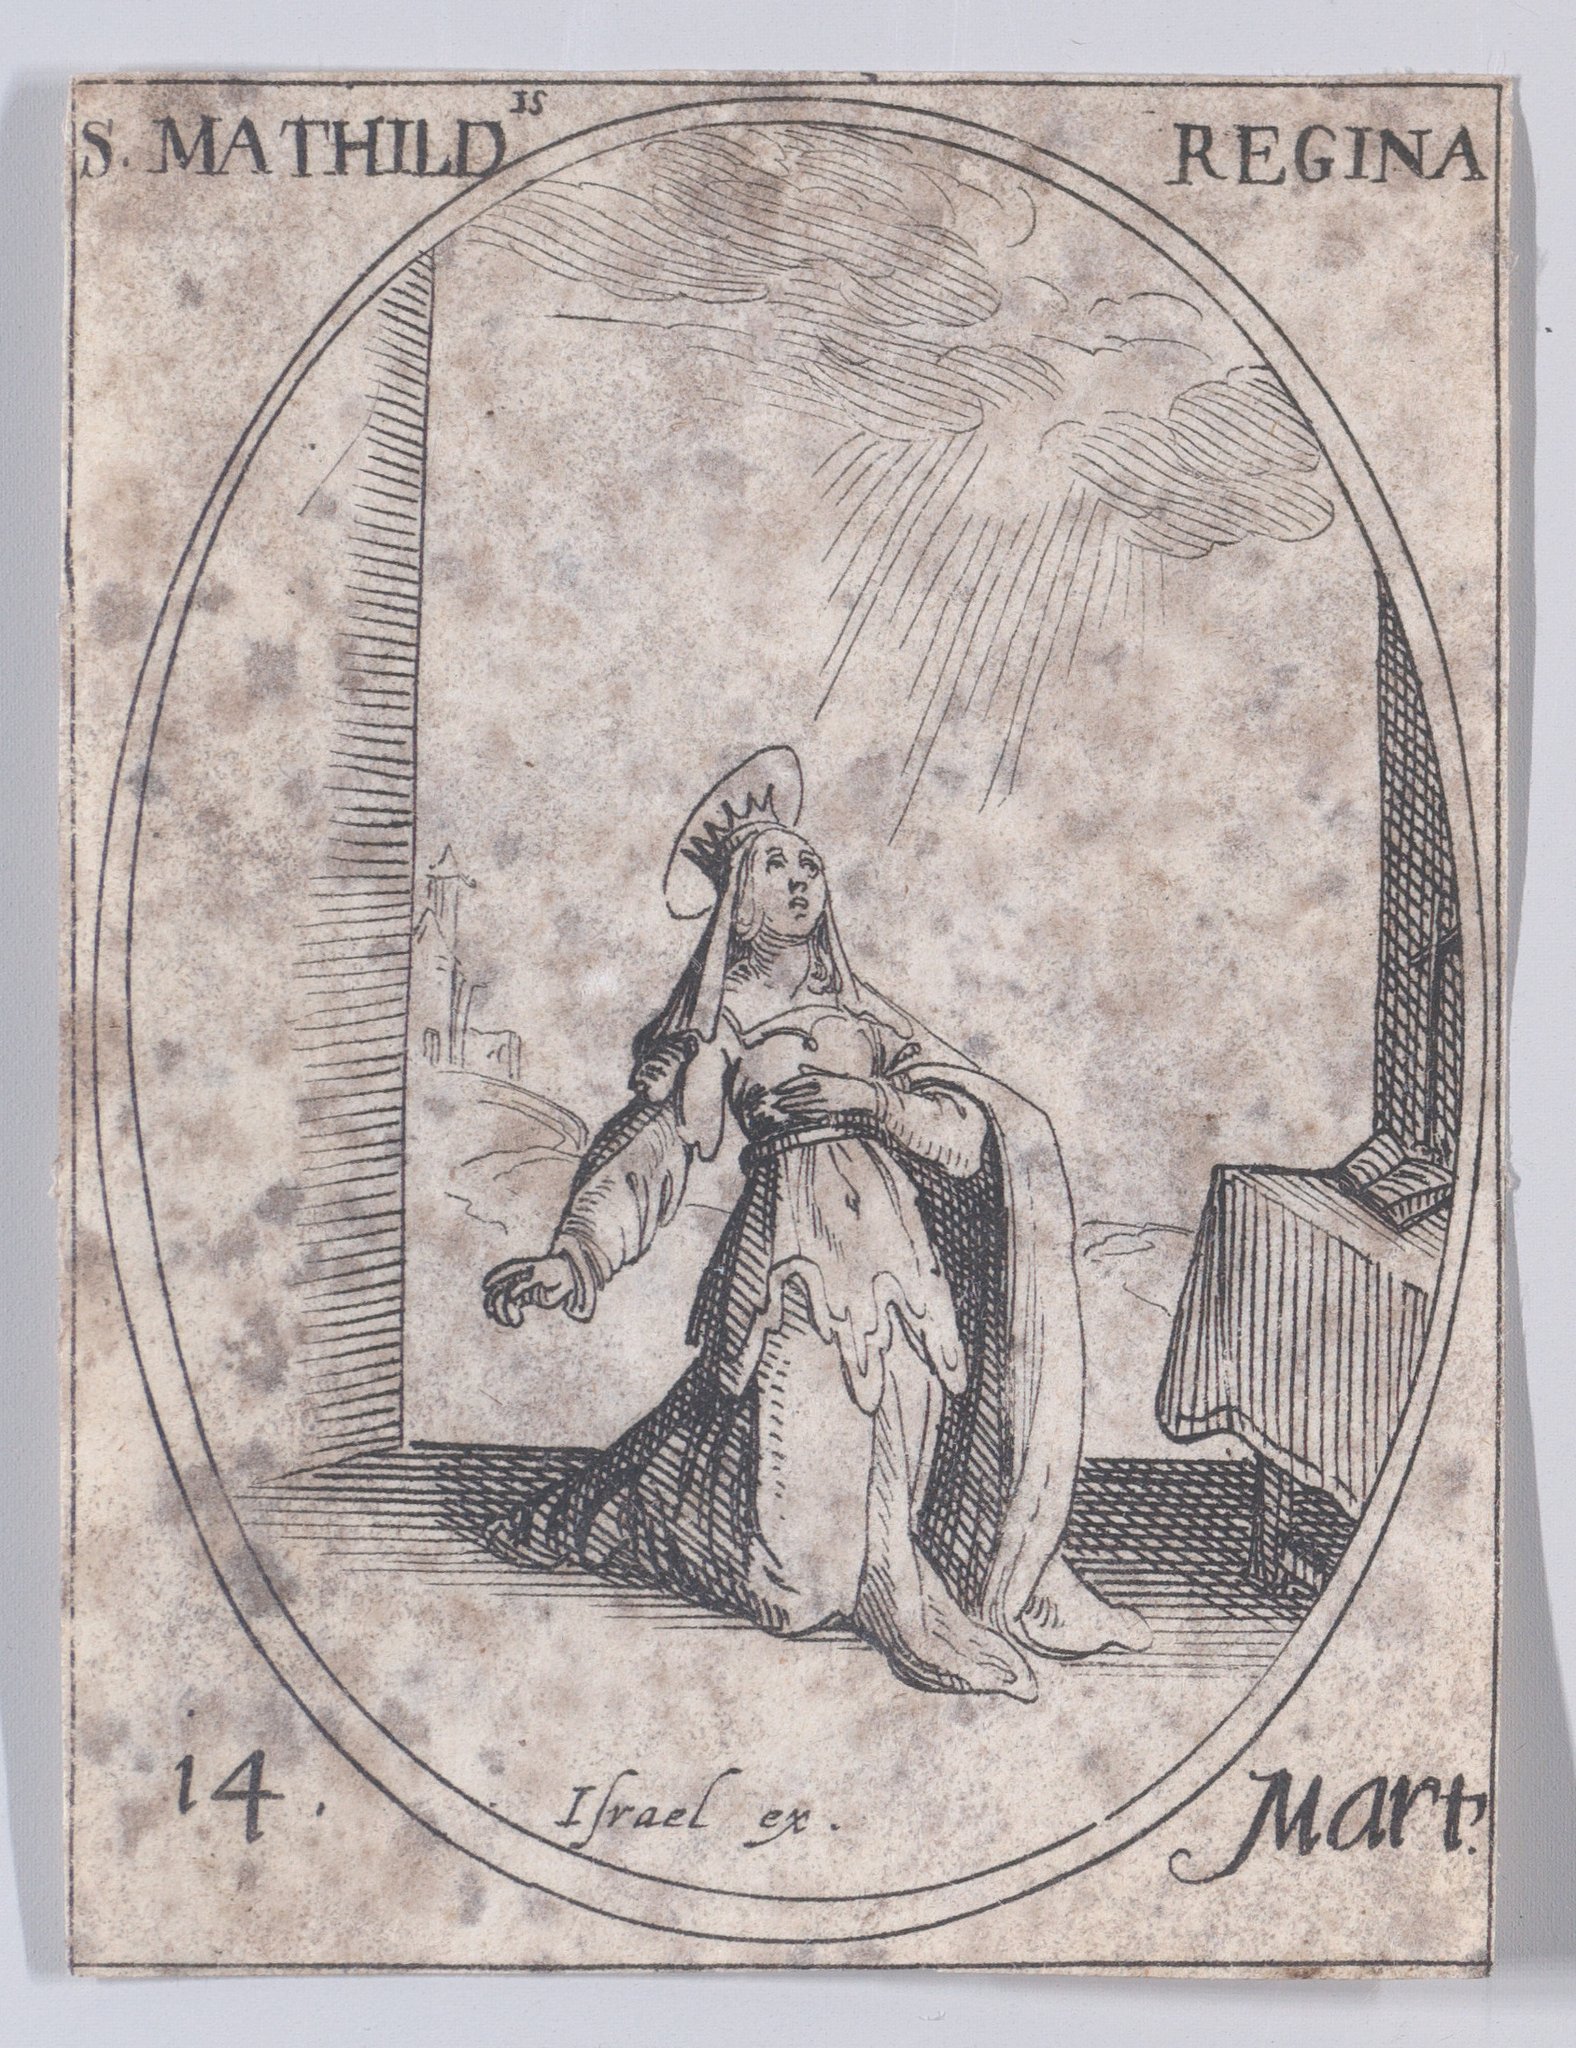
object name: print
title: Ste. Mathilde, reine (St. Matilda, Queen), March 14th, from "Les Images De Tous Les Saincts et Saintes de L'Année" (Images of All of the Saints and Religious Events of the Year)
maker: jacques callot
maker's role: artist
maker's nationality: french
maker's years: 1592-1635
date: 1636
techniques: etching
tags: queens,women,saints